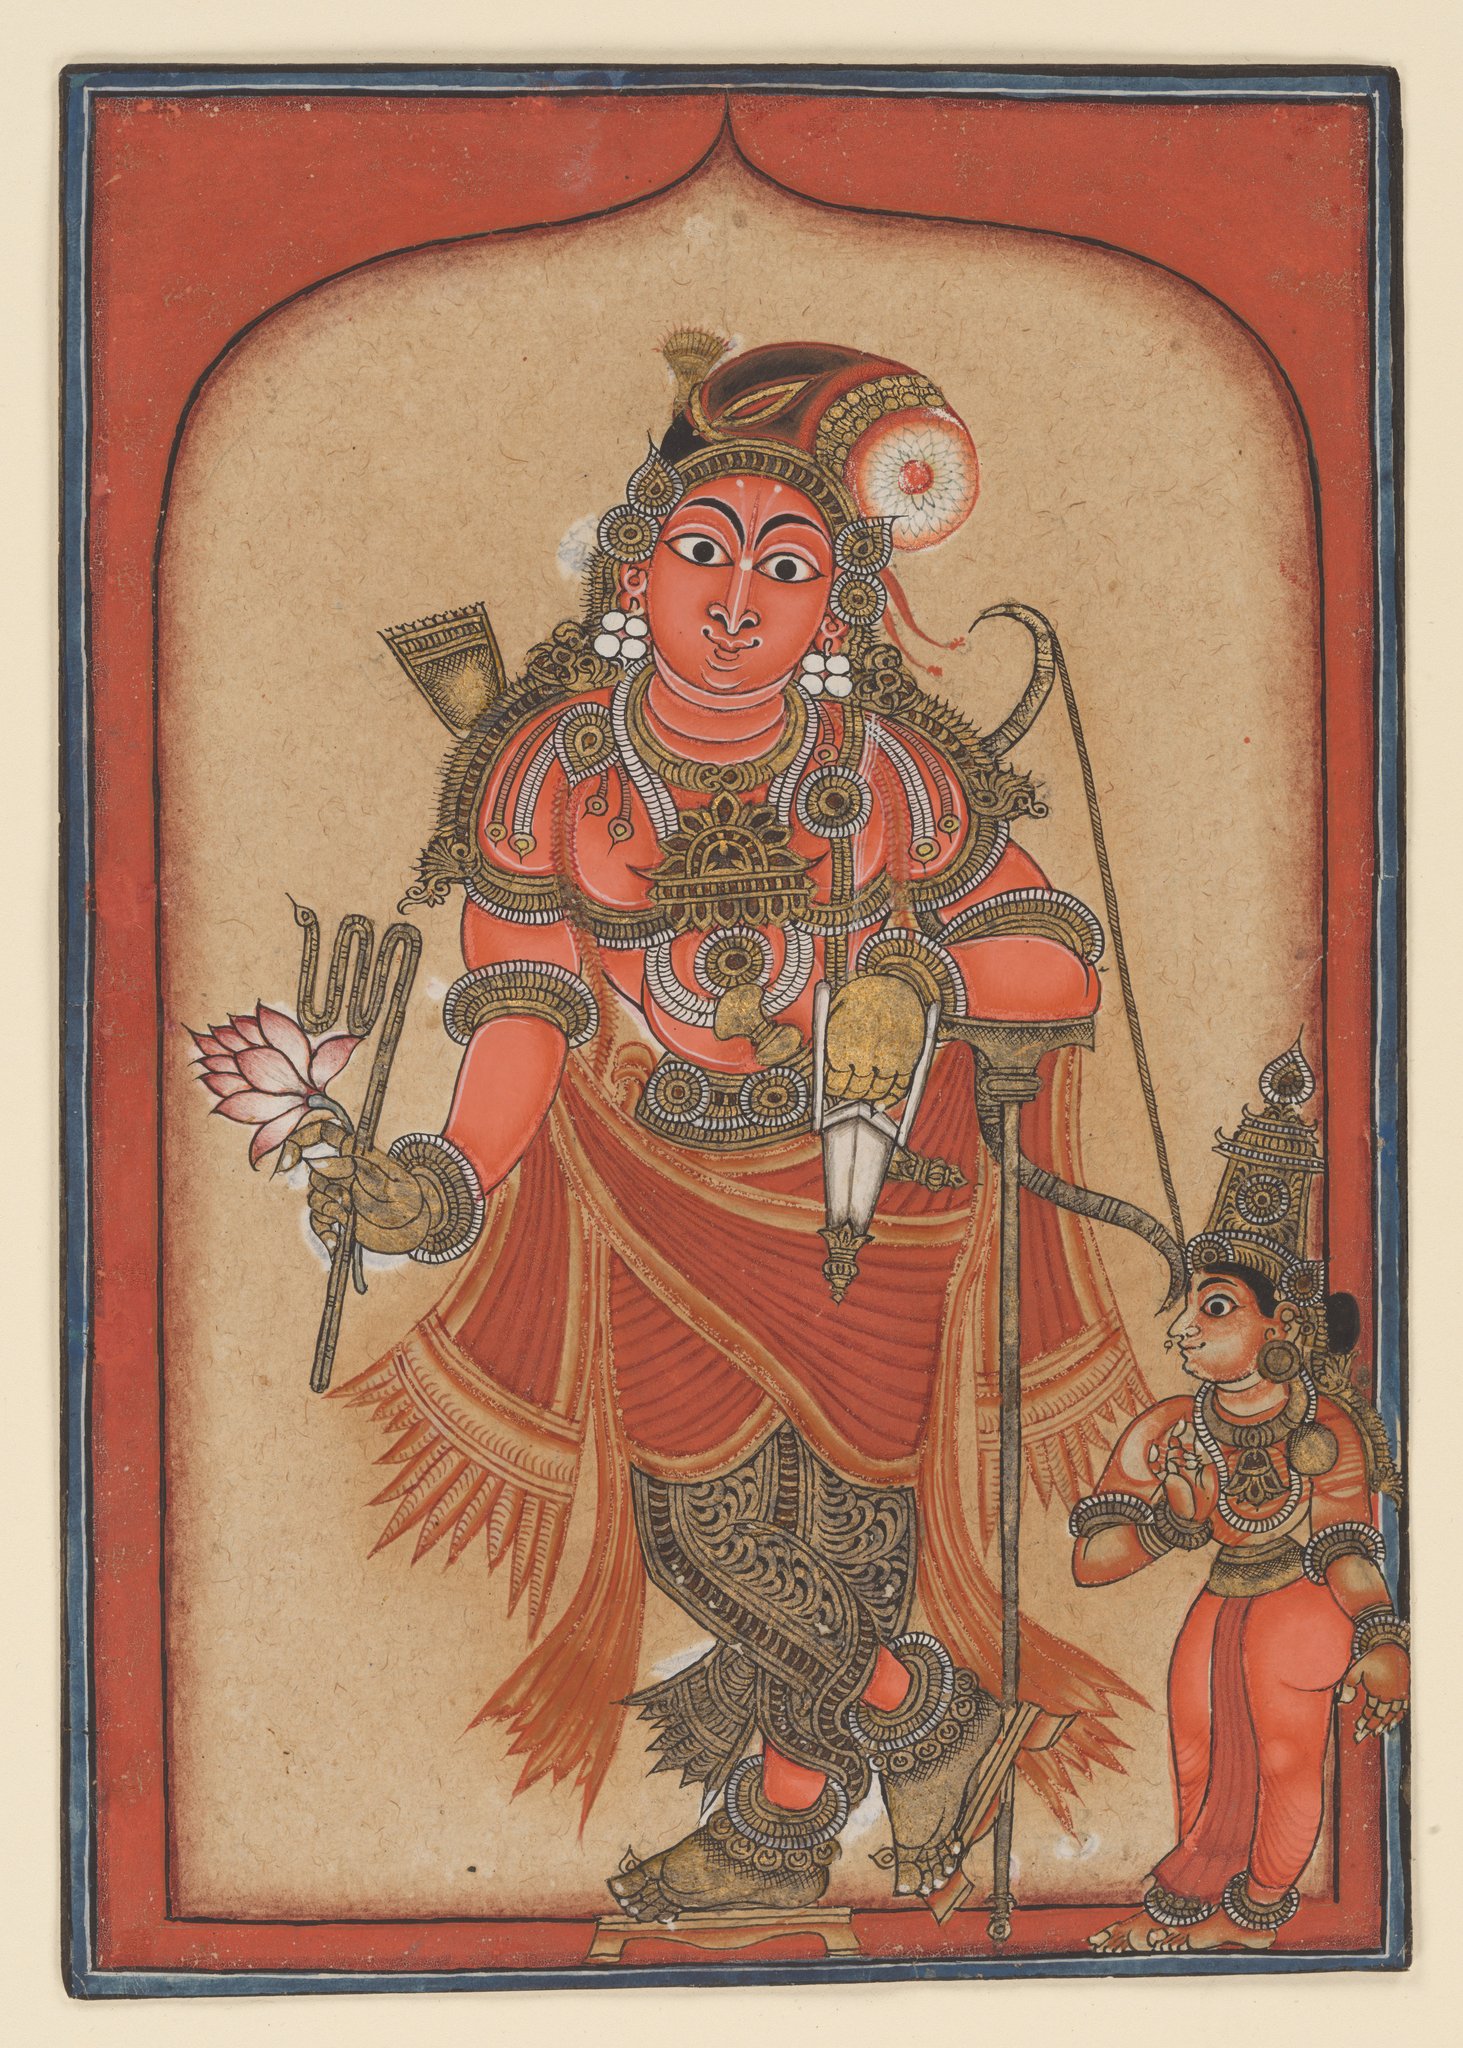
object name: painting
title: Krishna Rajagopalaswamy, king of the cowherds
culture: south indian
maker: tirupati school, south india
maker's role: artist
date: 1767-1800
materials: paper, silver, watercolor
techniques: hand coloring